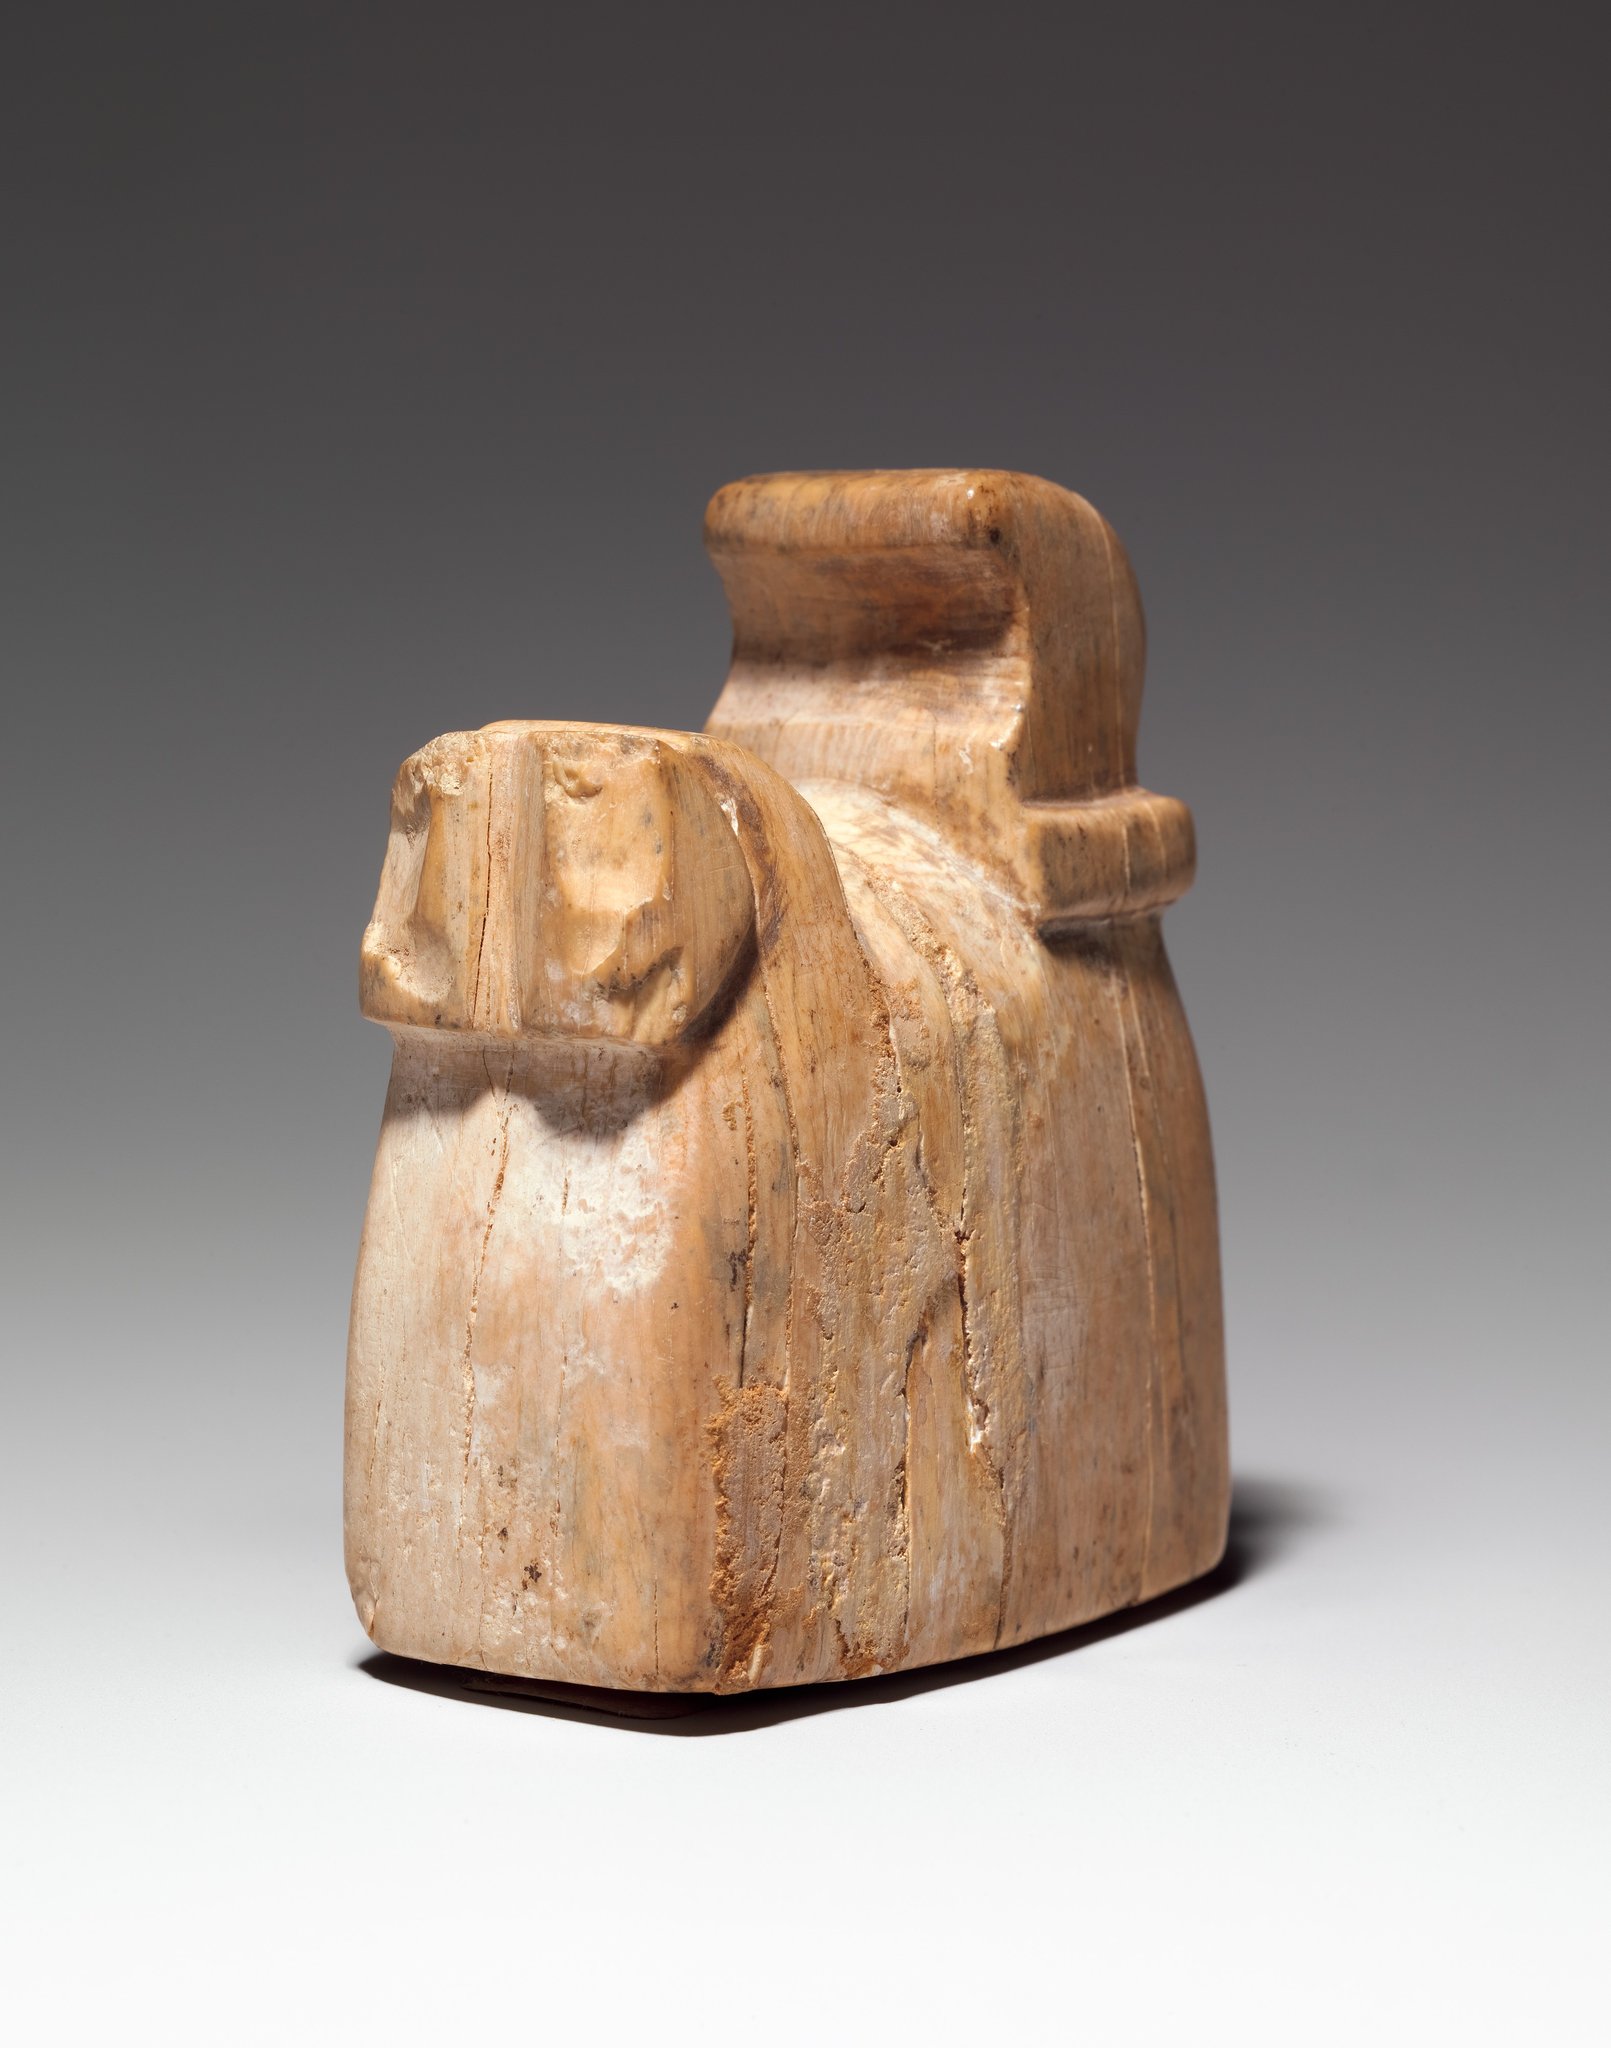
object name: chess piece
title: Chess Piece, Rook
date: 601-800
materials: ivory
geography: western islamic lands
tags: chess,games